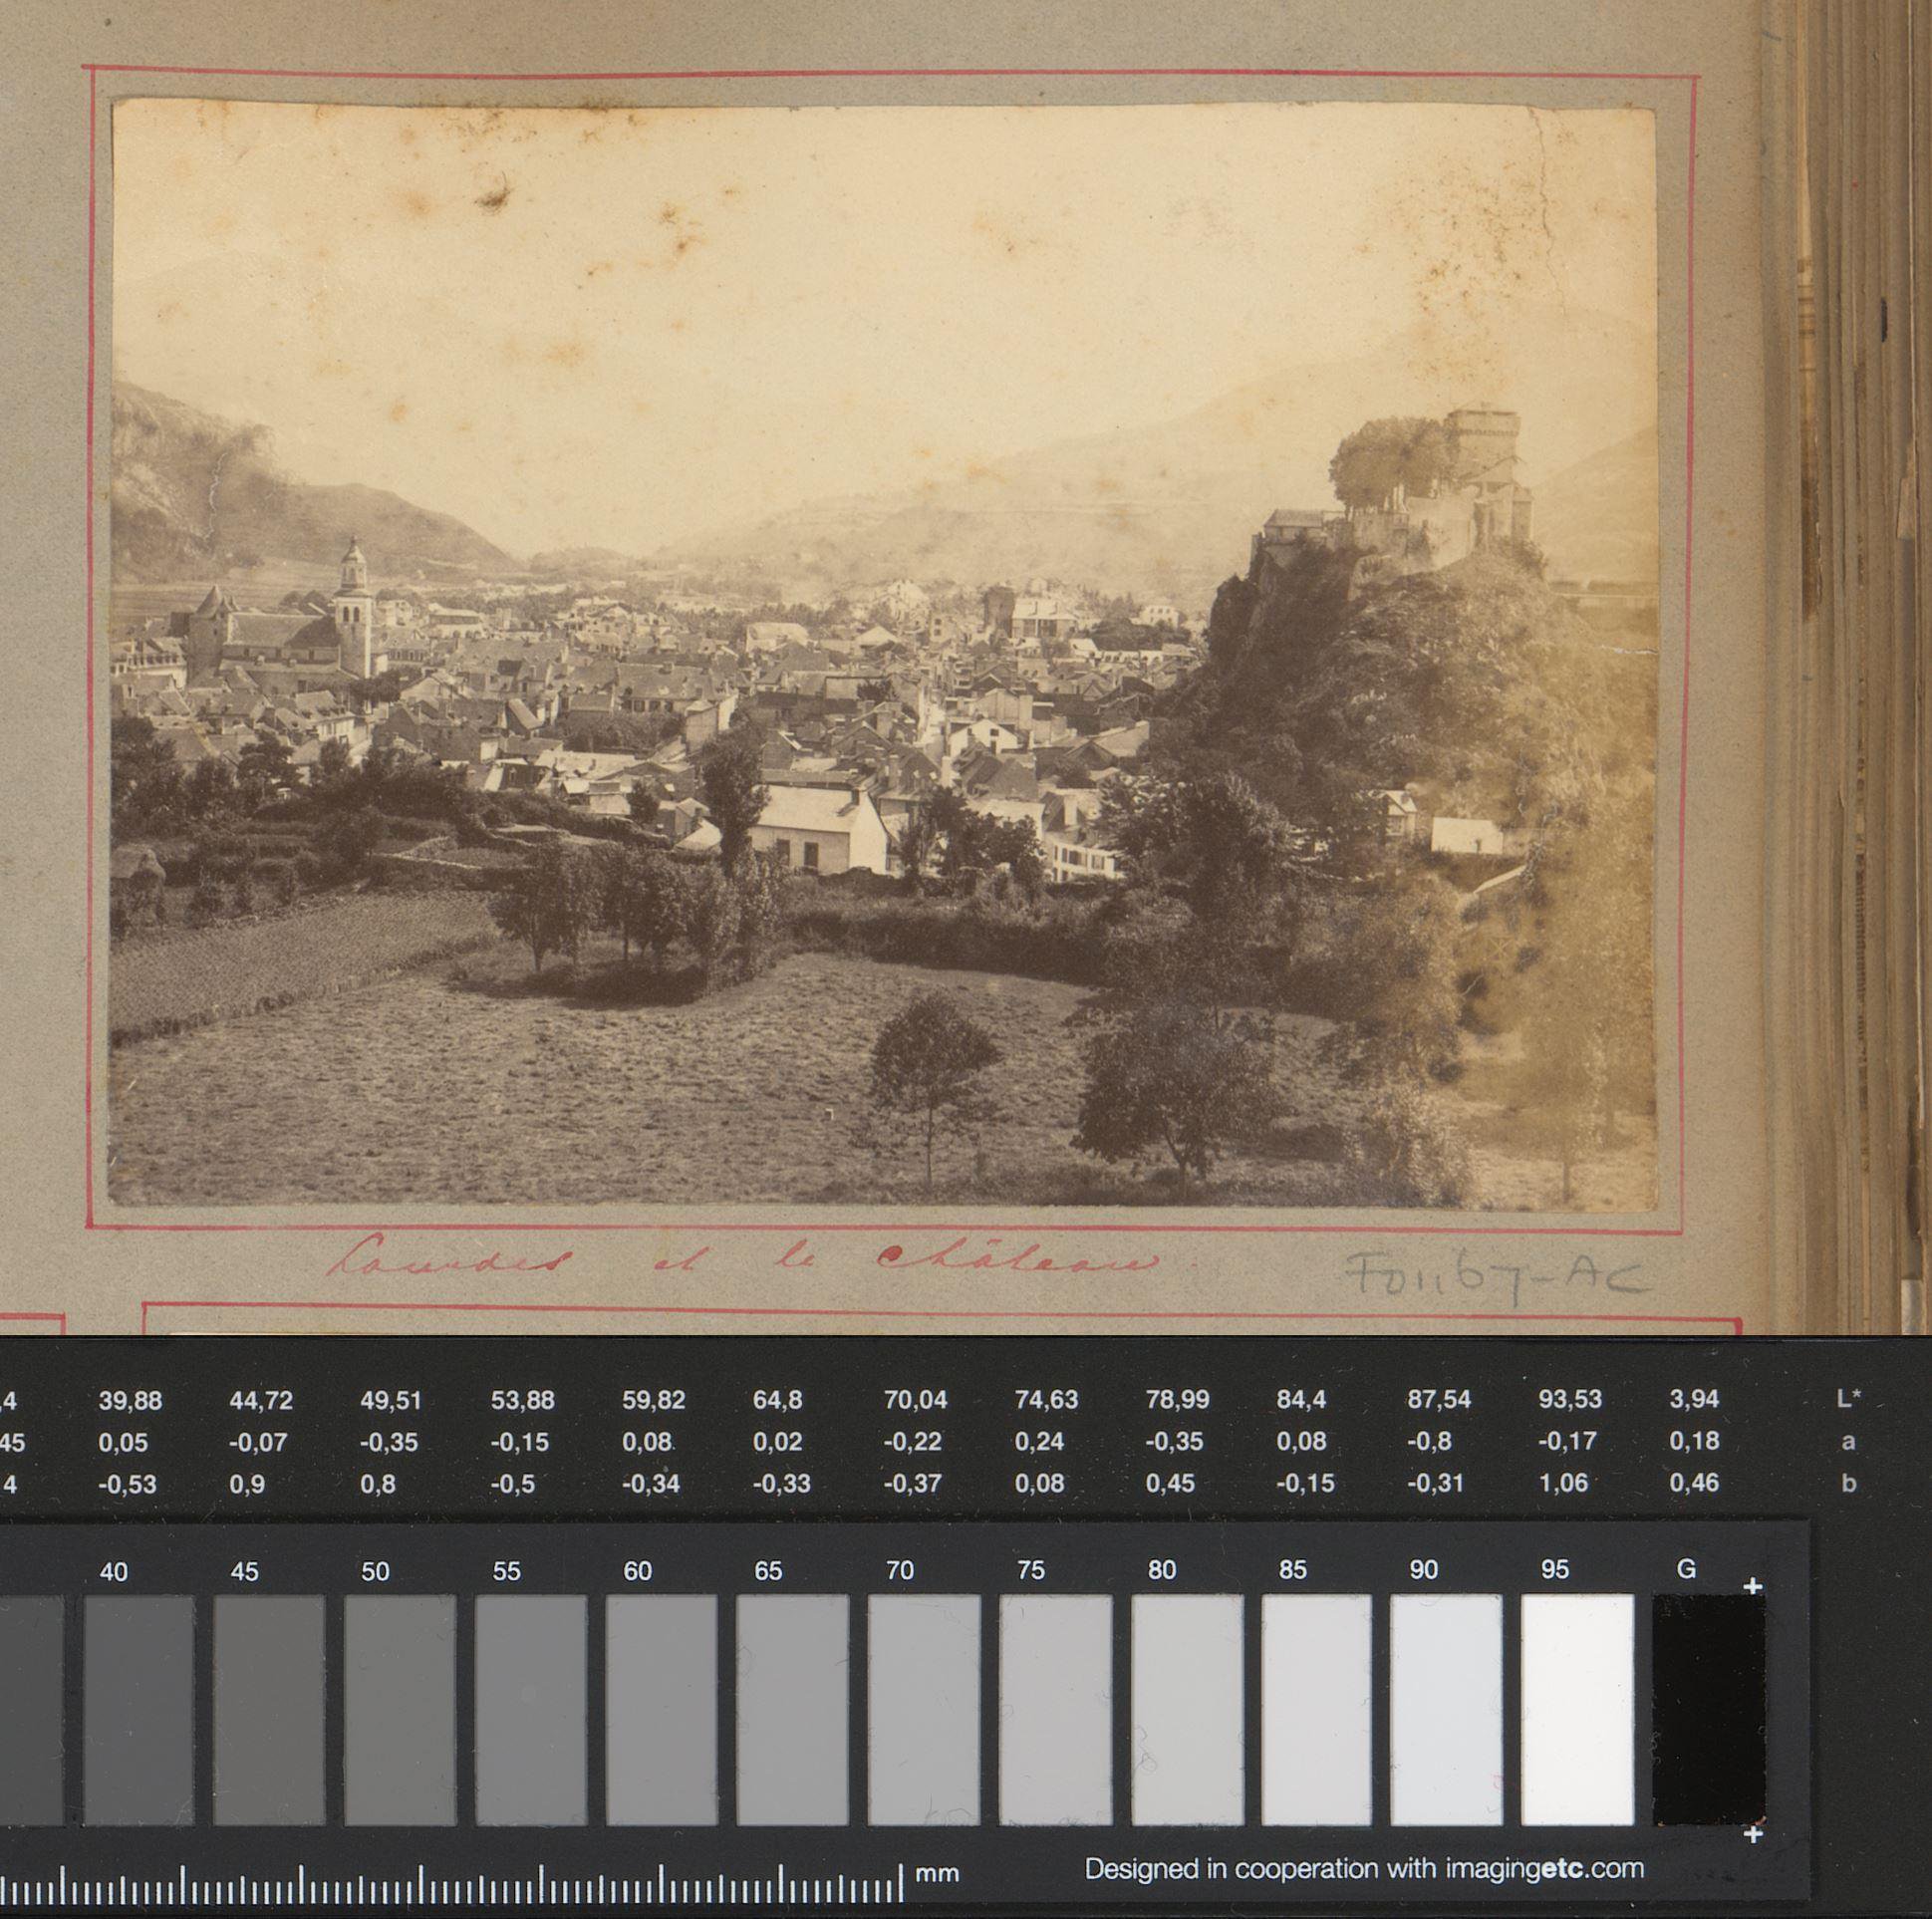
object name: photograph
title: Gezicht op Lourdes met Château fort de Lourdes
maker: Anonymous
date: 1880-1910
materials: photographic support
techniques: albumen print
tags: city-view in general; 'veduta', castle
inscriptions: annotation: ‘Lourdes et le château’